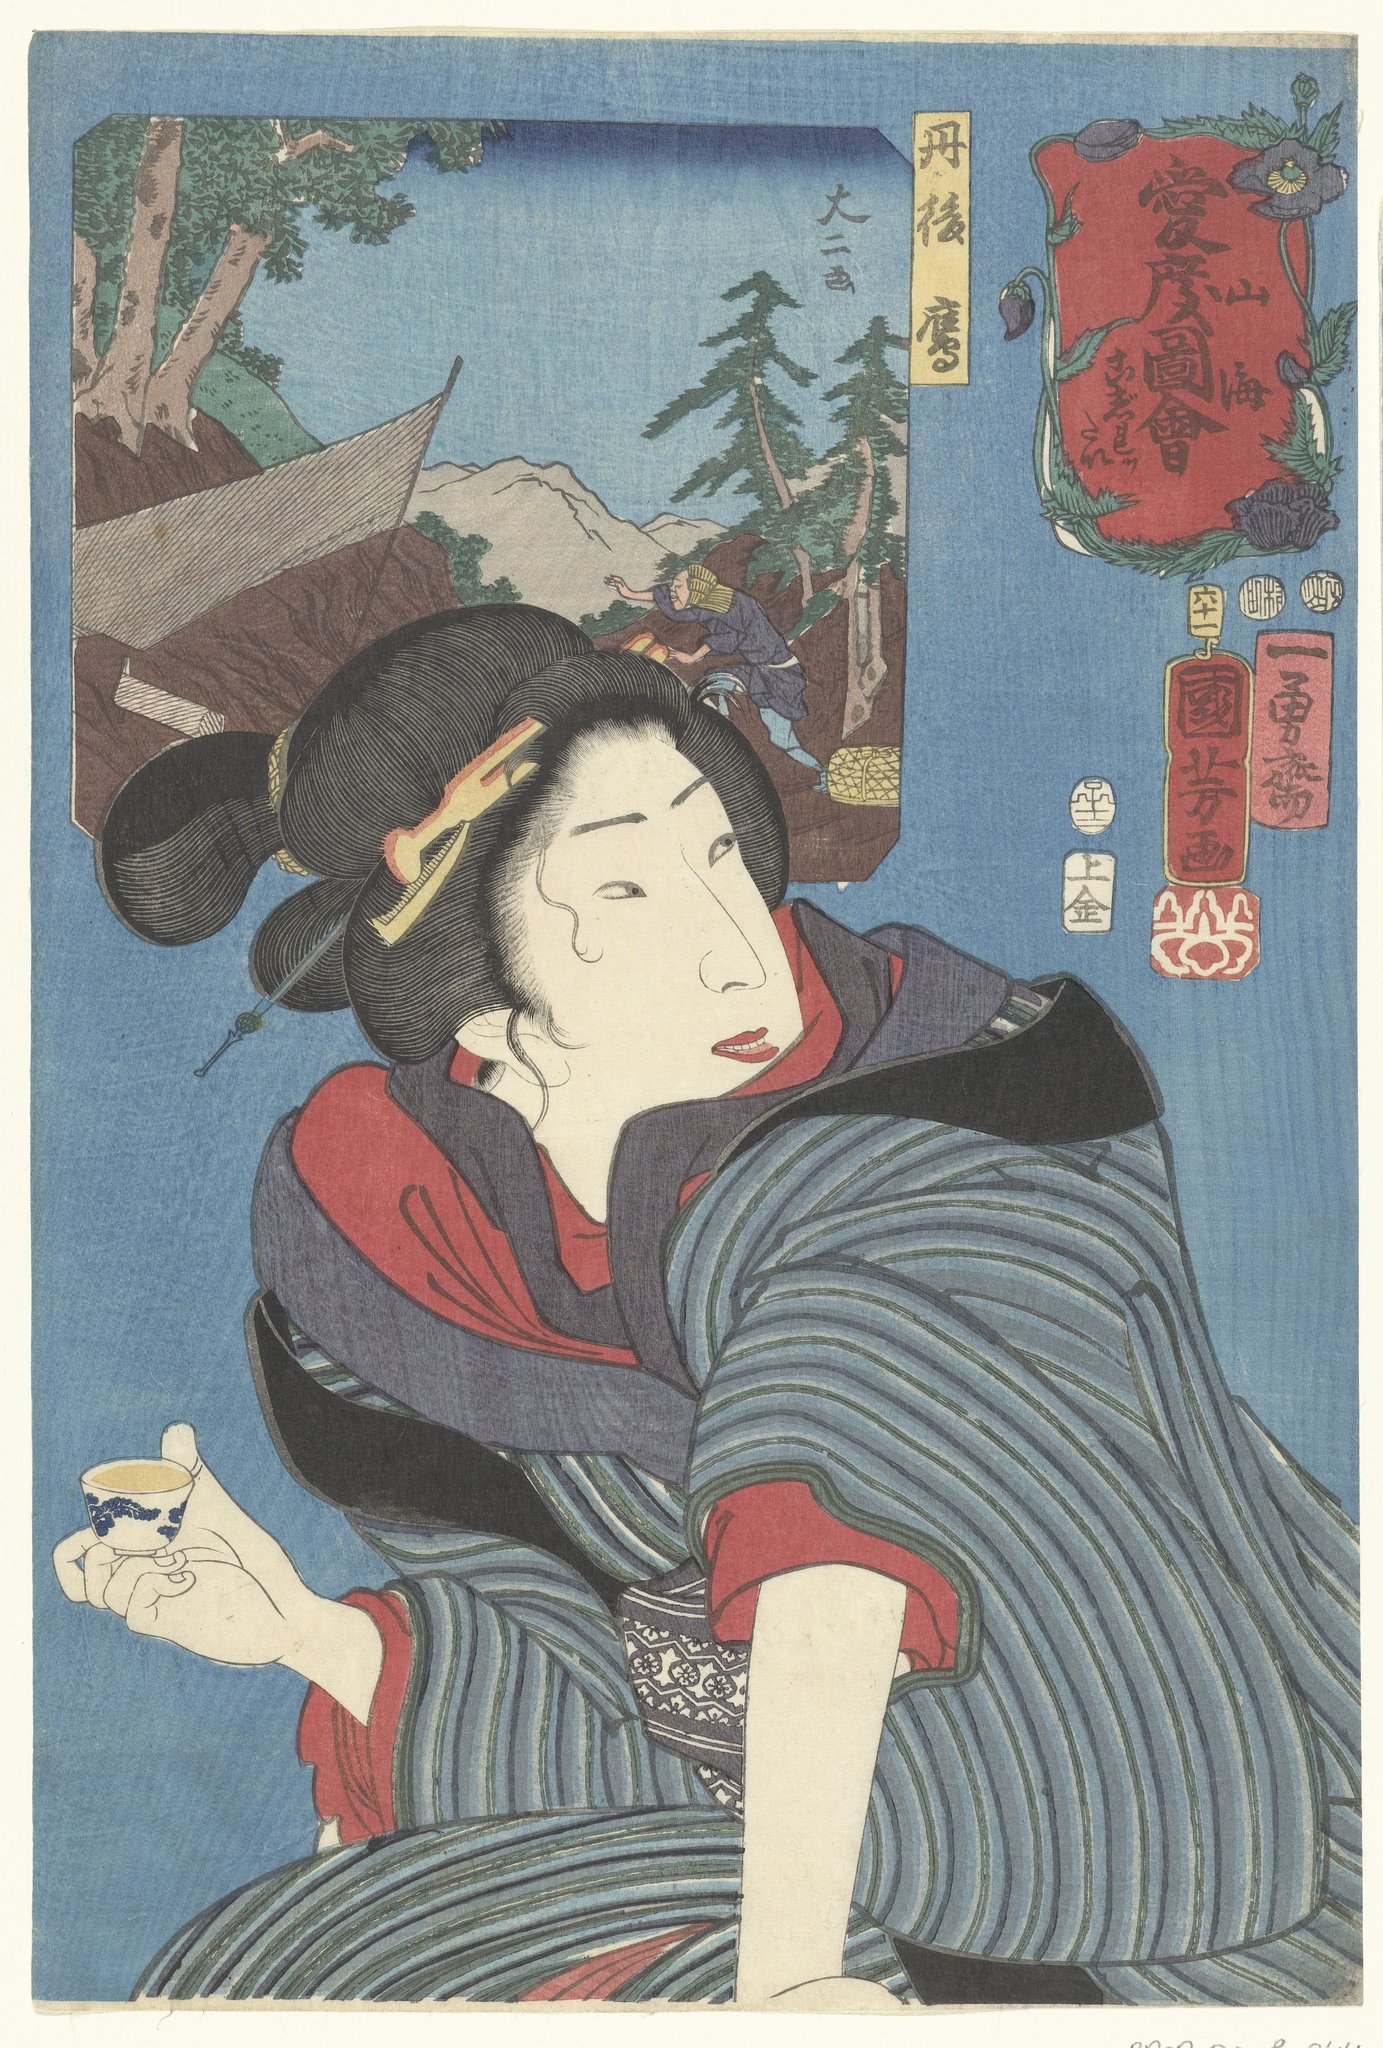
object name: print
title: Haviken uit de provincie Tango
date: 1852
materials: paper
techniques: woodcut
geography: japan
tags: adult woman, cup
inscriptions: date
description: Japanse vrouw, met kopje in rechter hand, over haar linker schouder naar achter kijkend. Cartouche links boven met berglandschap waarin man lopend naar bij bomen gespannen net.